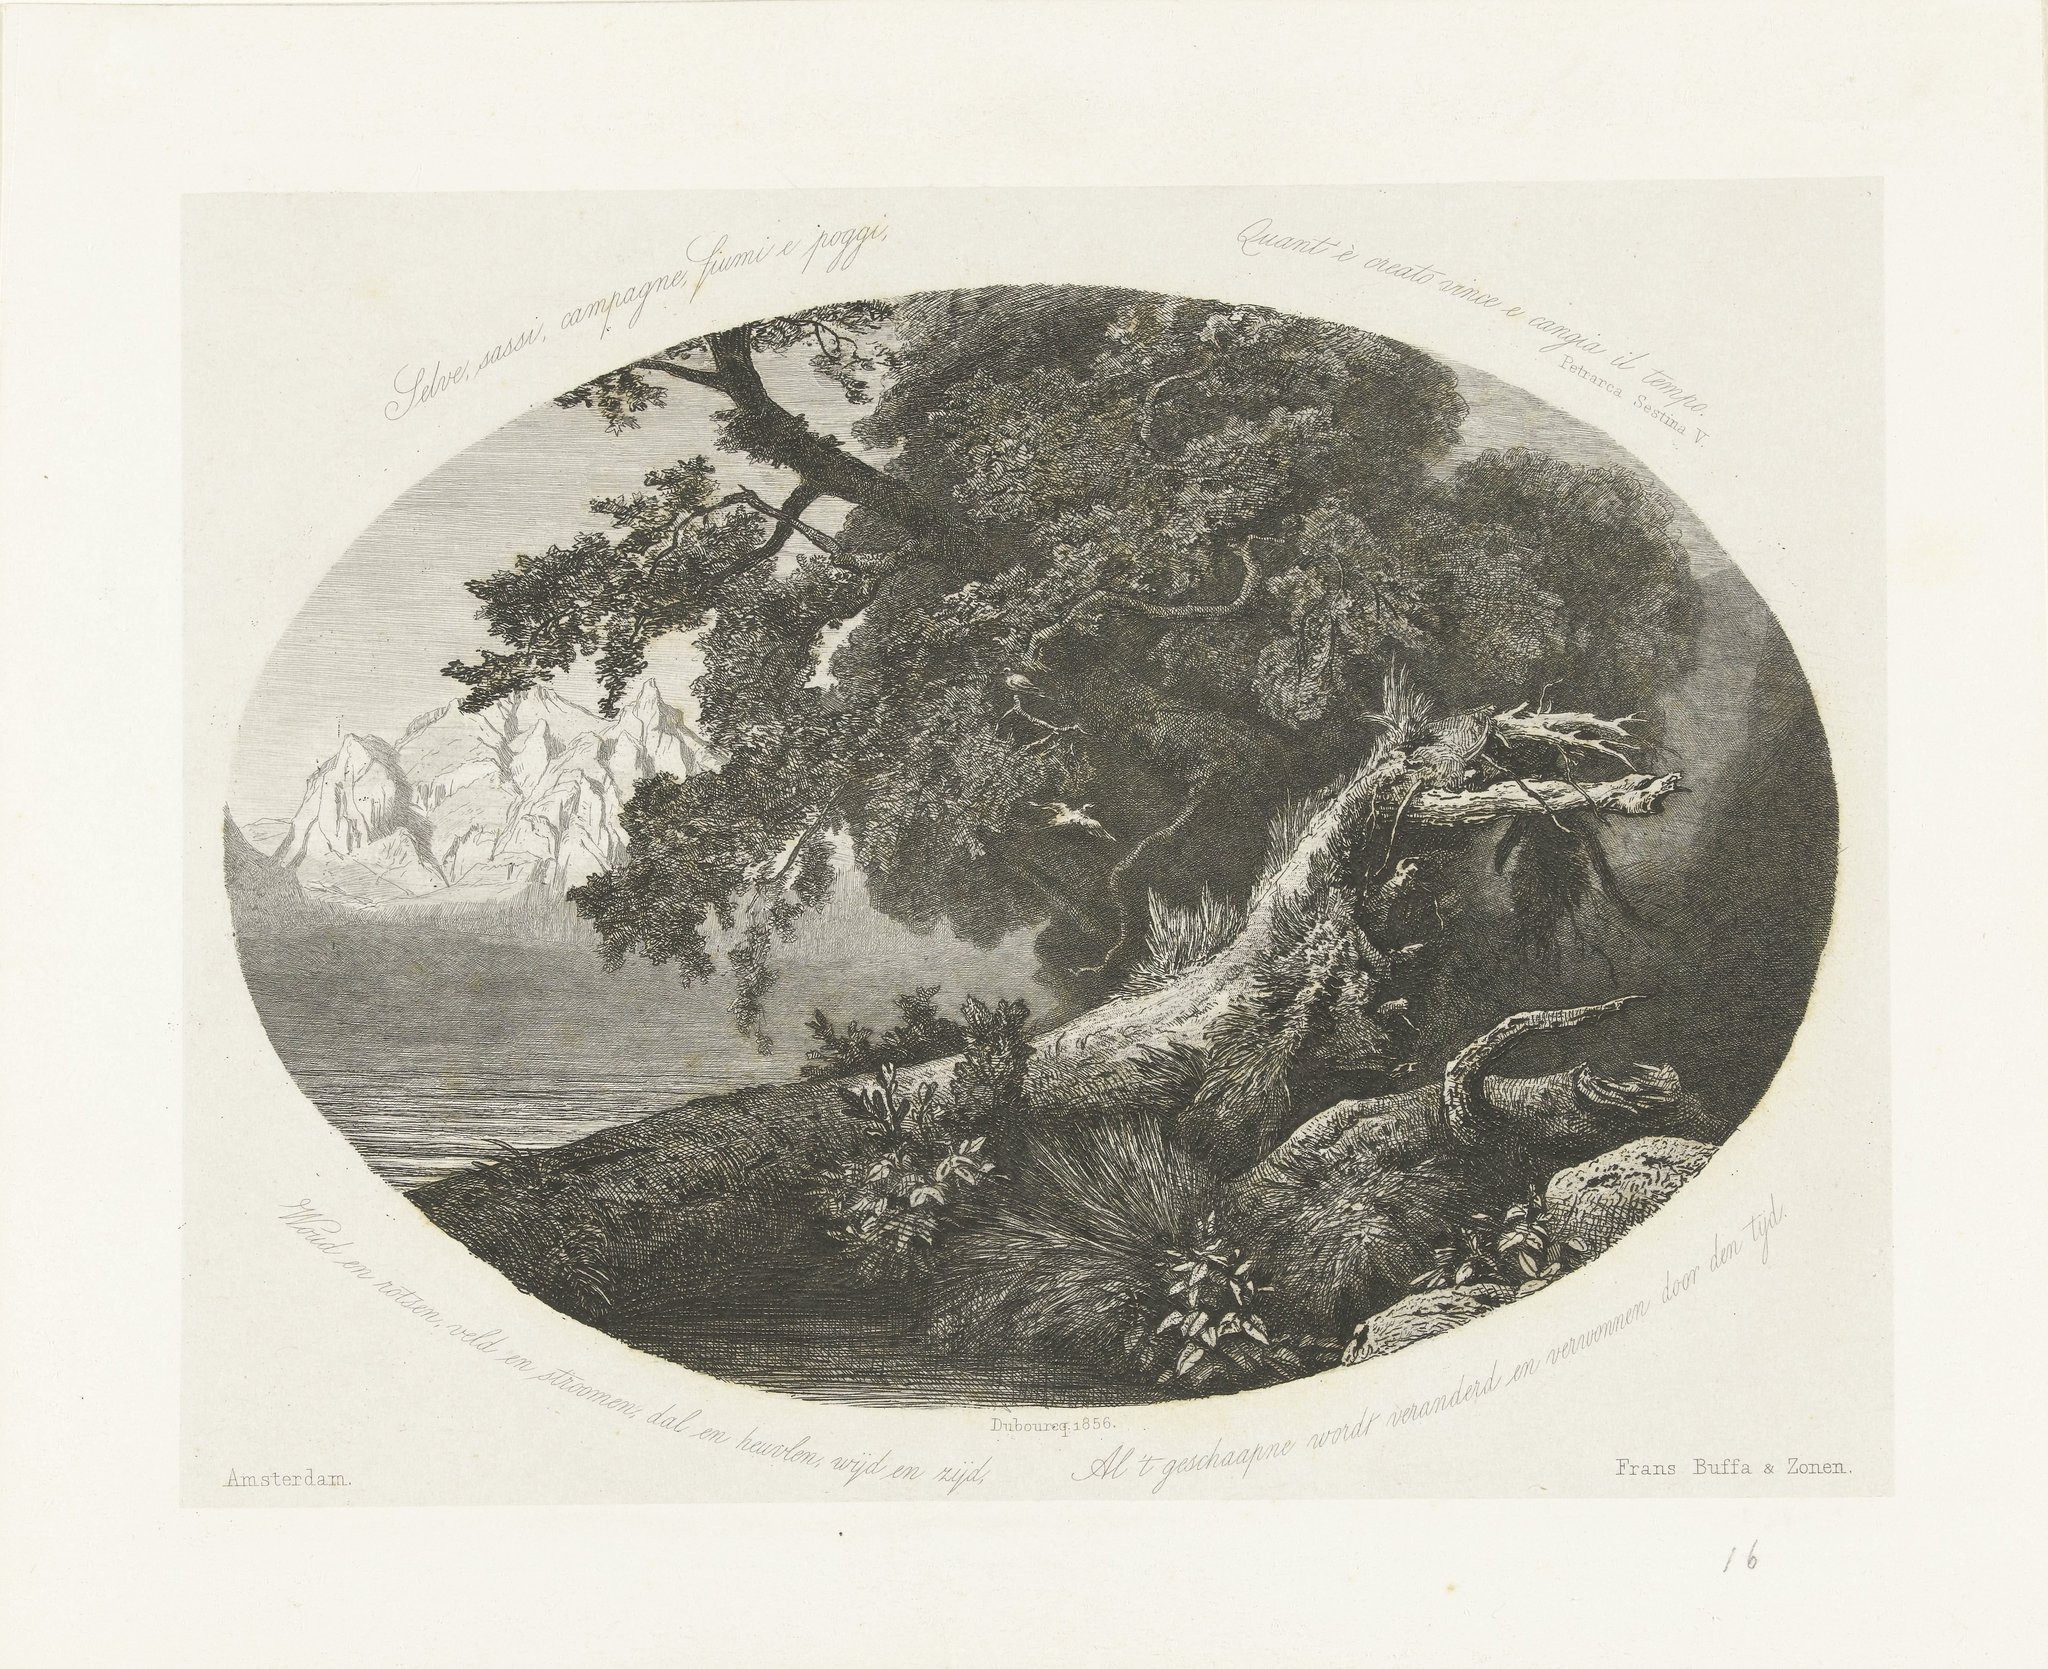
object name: print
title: Ontwortelde boomstam aan de kust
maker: pierre louis dubourcq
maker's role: draughtsman, painter, print maker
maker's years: 1815-1873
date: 1856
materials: paper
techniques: drypoint, etching, roulette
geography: amsterdam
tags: groups of trees, mountain-range, snow peaks, coast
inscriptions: collector's mark: Lugt 1485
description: Aan de kust van een meer ligt een ontwortelde boomstam. Aan de overkant zijn sneeuwbedekte bergtoppen te zien. Om de afbeelding heen een vers van Petrarca over de vergankelijkheid van de natuur, in het Italiaans en Nederlands.